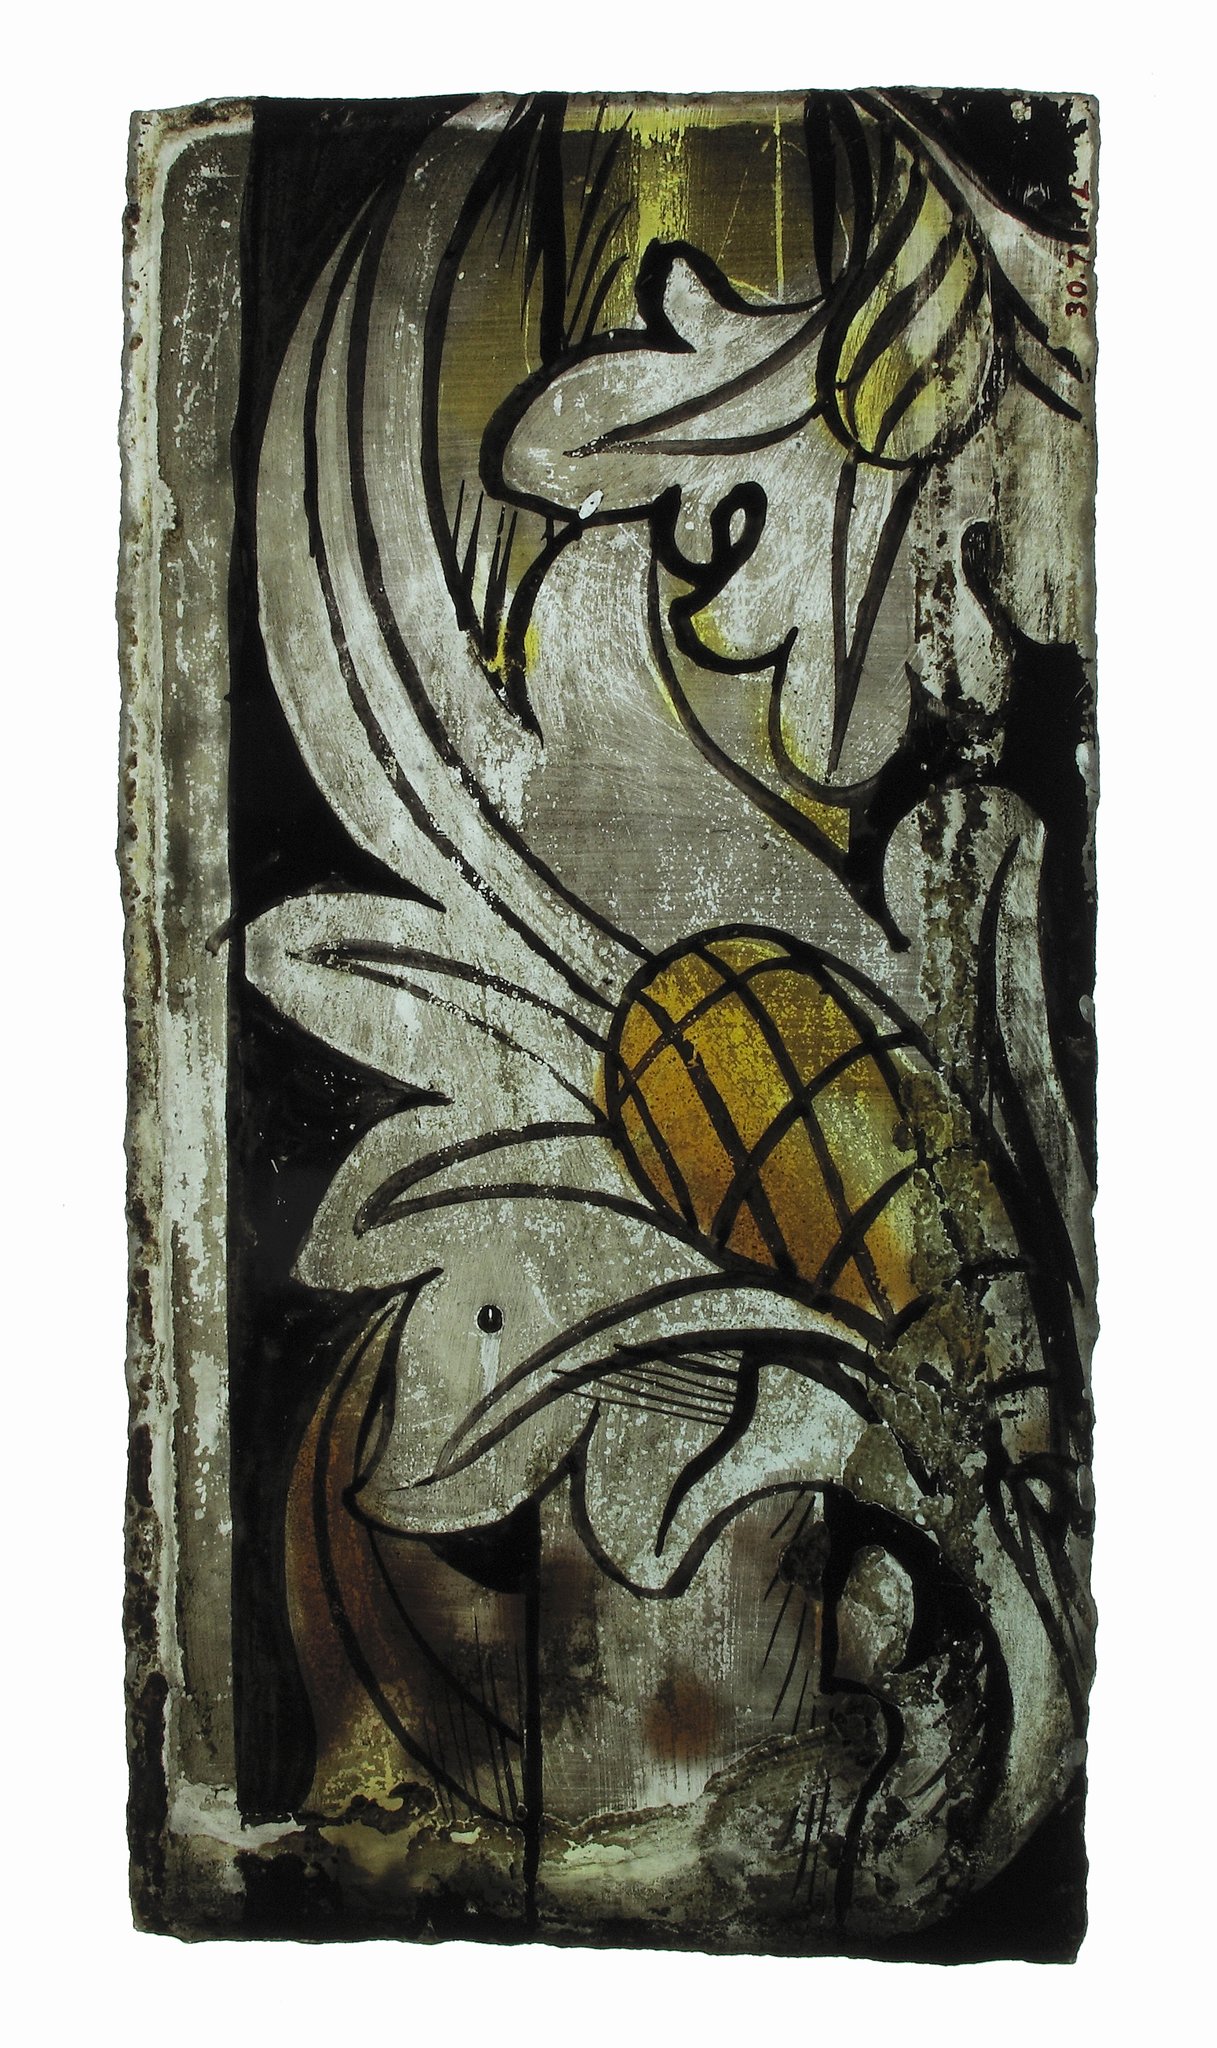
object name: fragment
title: Glass Fragment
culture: european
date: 1501-1533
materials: glass